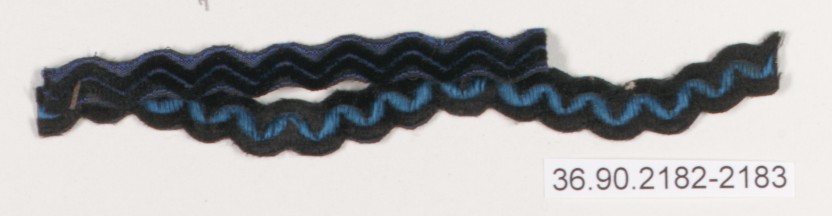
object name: piece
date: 1801-1900